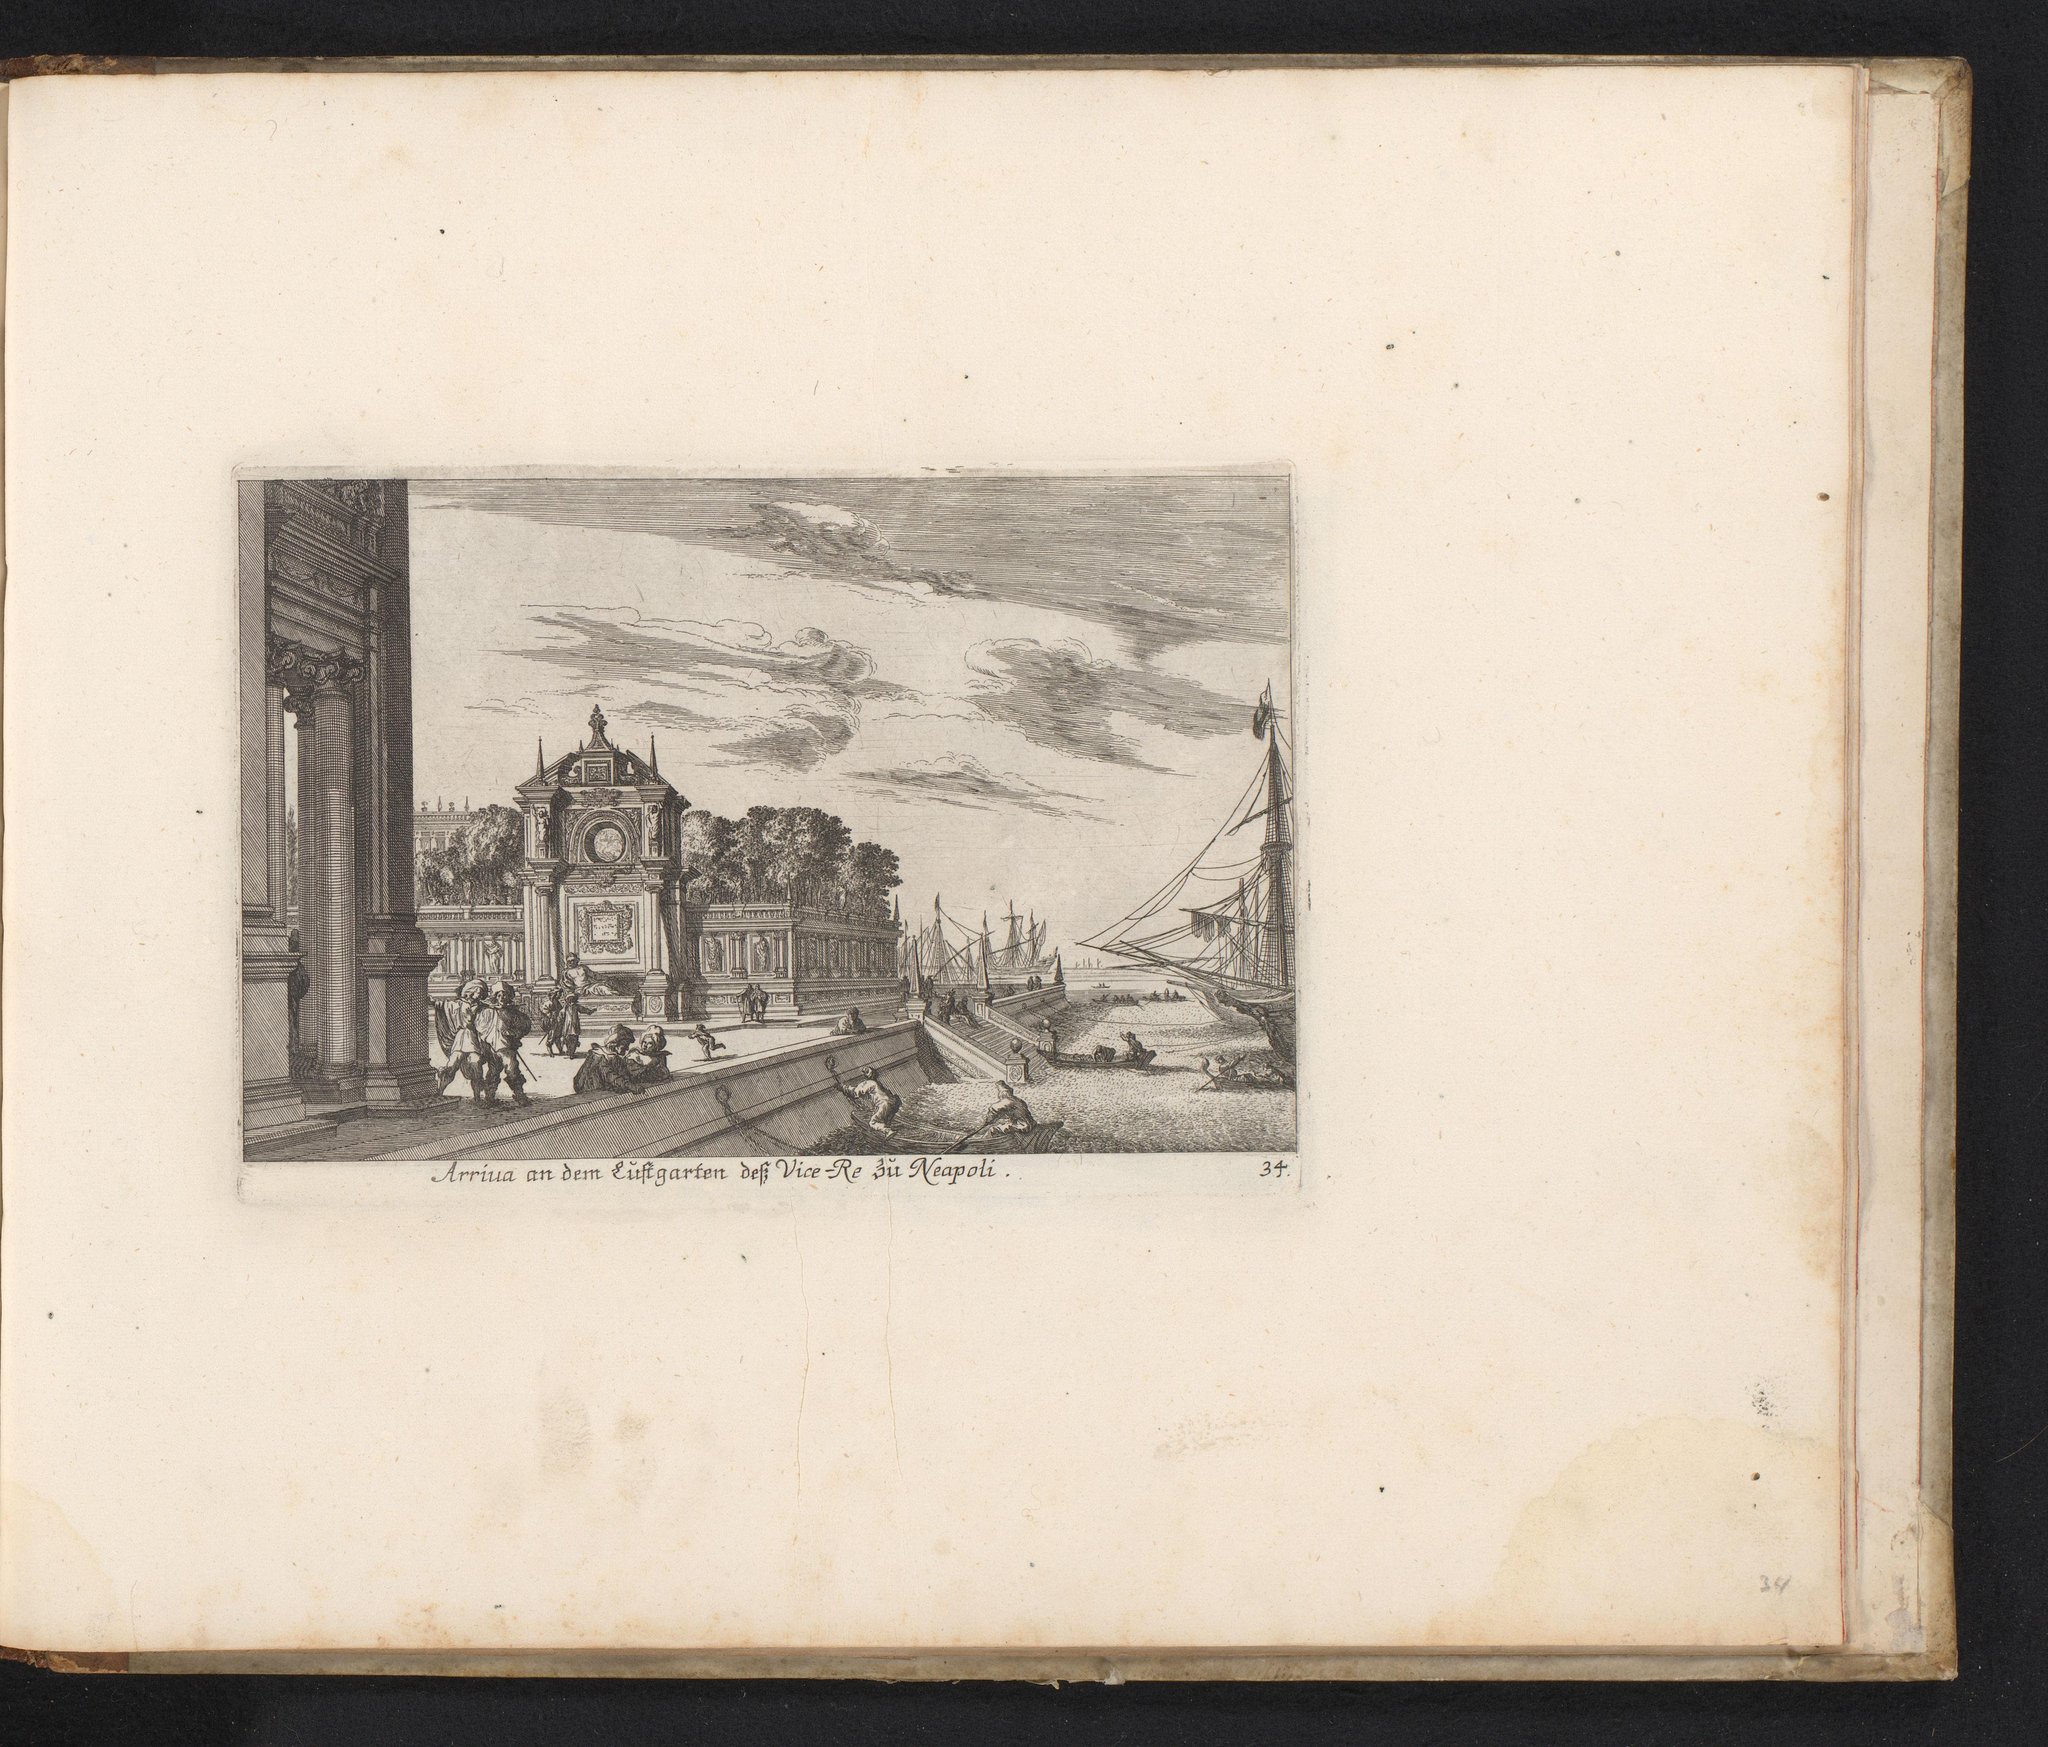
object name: album leaf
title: Werf gelegen aan de tuin van het koninklijk paleis in Napels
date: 1670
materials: paper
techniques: etching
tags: garden, pier, quay, wharf (+ four persons or more ~ traffic and transport), naples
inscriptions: collector's mark: Lugt 2228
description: Tekst in het Duits in de ondermarge. Rechtsonder genummerd: 34. Prent maakt deel uit van een album.